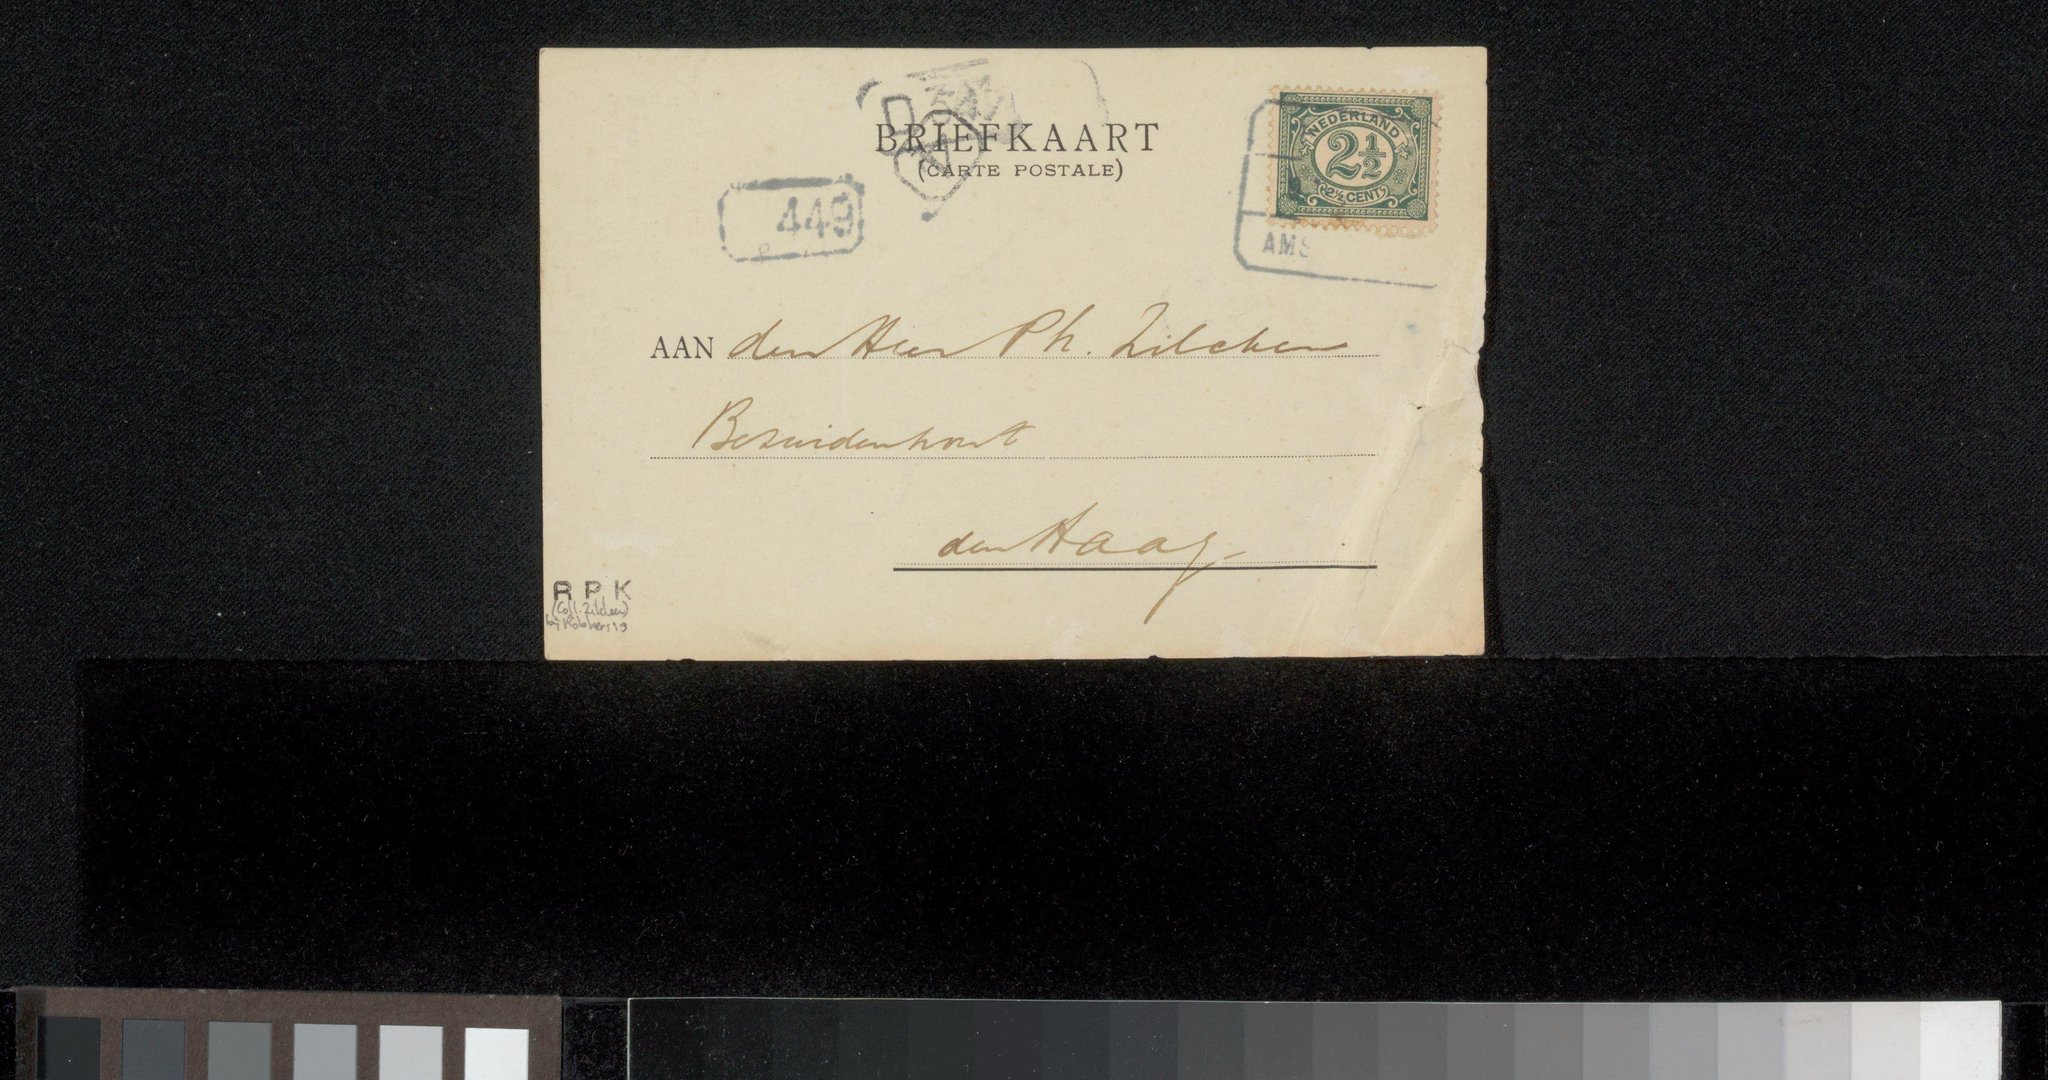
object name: postcard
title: Briefkaart aan Philip Zilcken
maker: herman robbers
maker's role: redacteur, schrijver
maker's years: 1868-1937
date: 1916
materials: cardboard, ink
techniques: pen, printing, writing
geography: schoorl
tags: painter, draughtsman, philip zilcken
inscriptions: collector's mark: ‘RPK’